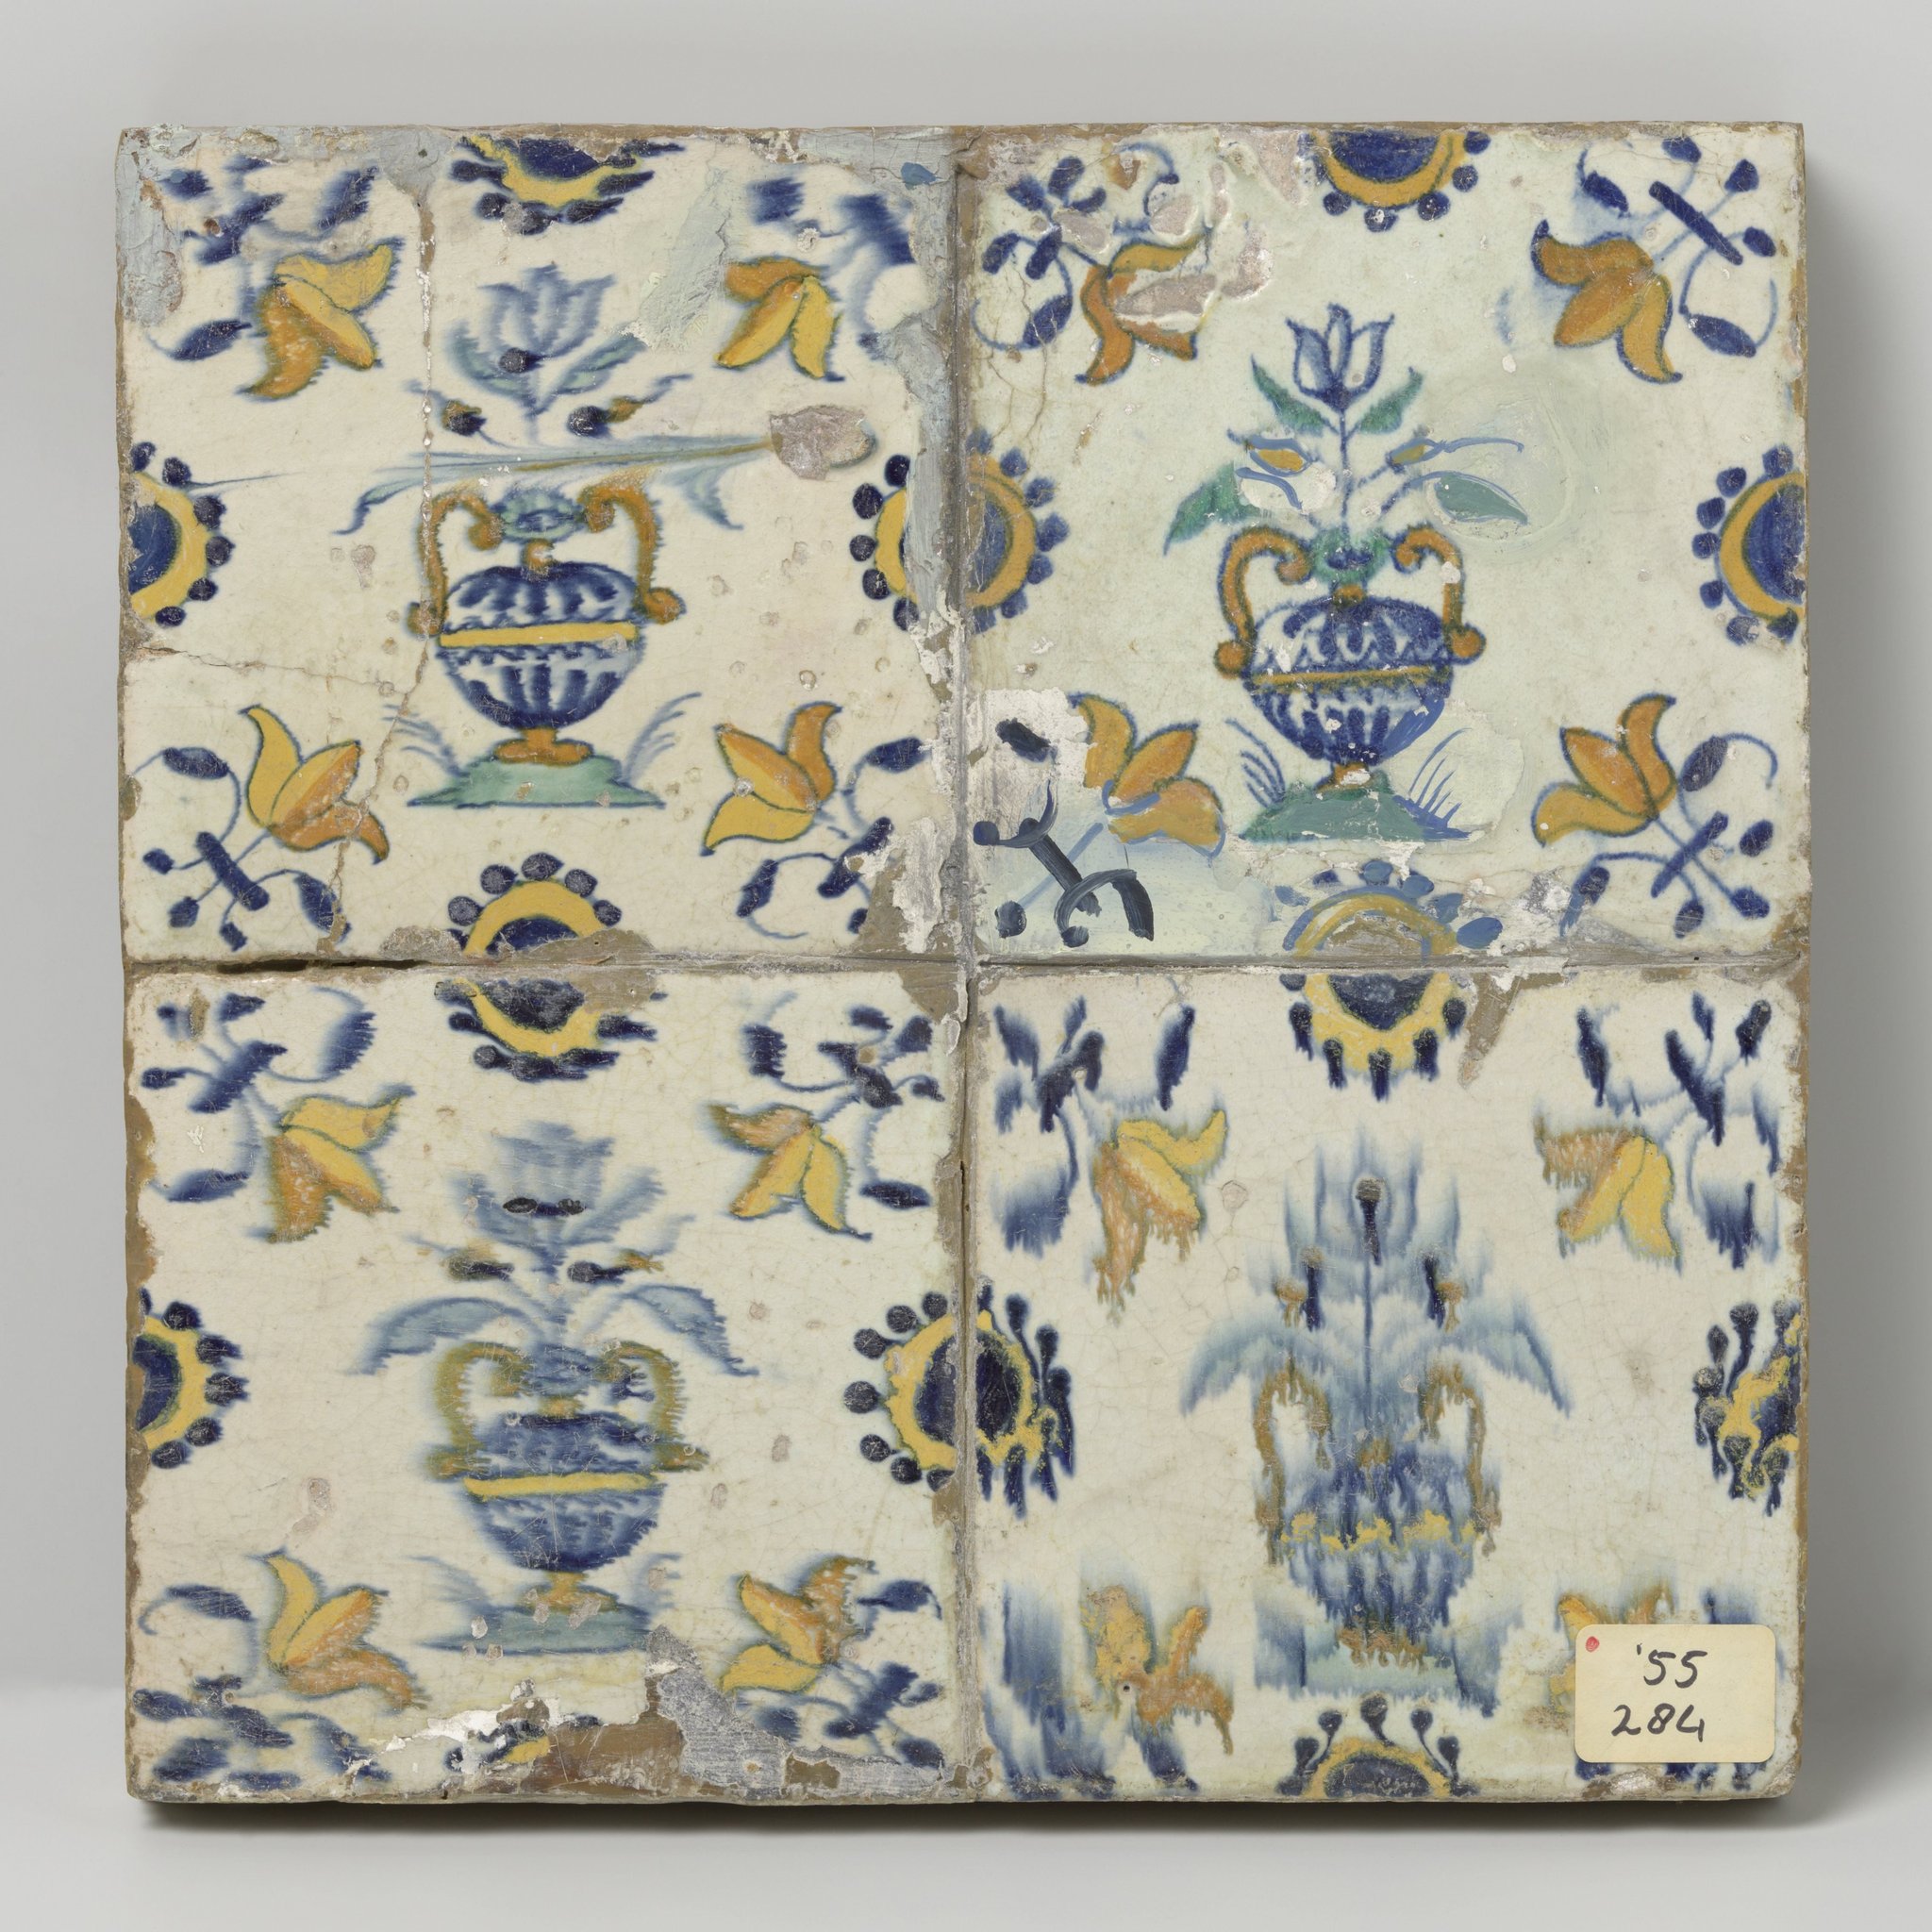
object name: tile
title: Veld van vier tegels met bloempotten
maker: Anonymous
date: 1640-1660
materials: earthenware, glaze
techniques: maiolica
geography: netherlands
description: Veld van vier tegels (2 x 2) elk met een veelkleurig (blauw, groen, geel en oranje) geschilderde bloempot. Langs de randen een halve rozet en in de hoeken, een lelie.